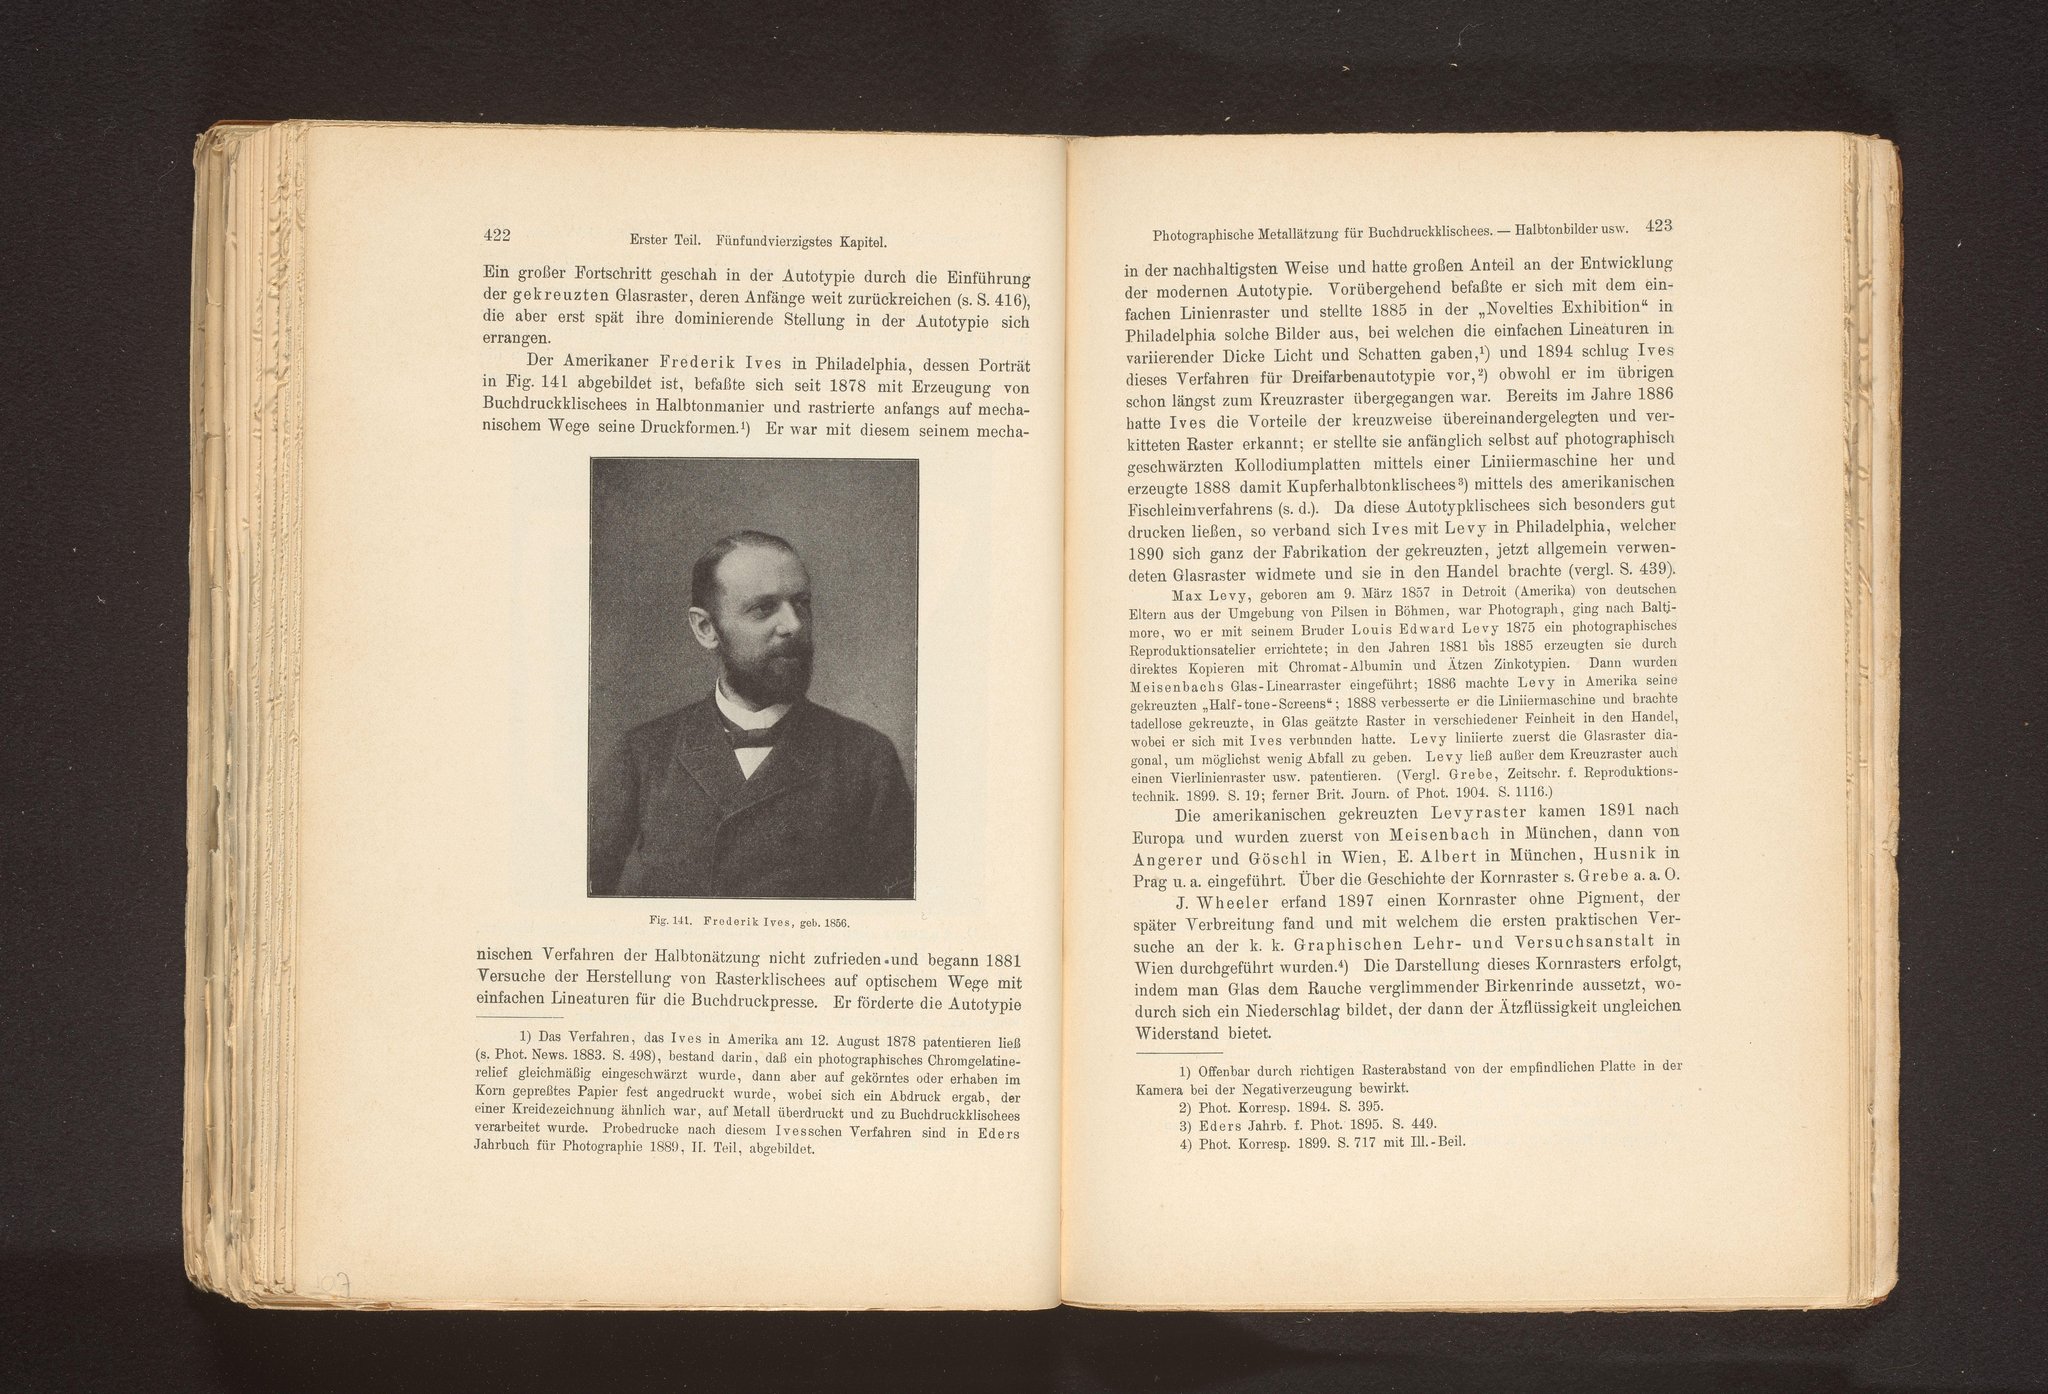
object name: page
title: Portret van Frederic Eugene Ives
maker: Anonymous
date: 1900-1905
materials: paper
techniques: autotype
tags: frederic eugene ives, portrait, self-portrait of photographer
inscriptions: number: ‘Fig. 141.’